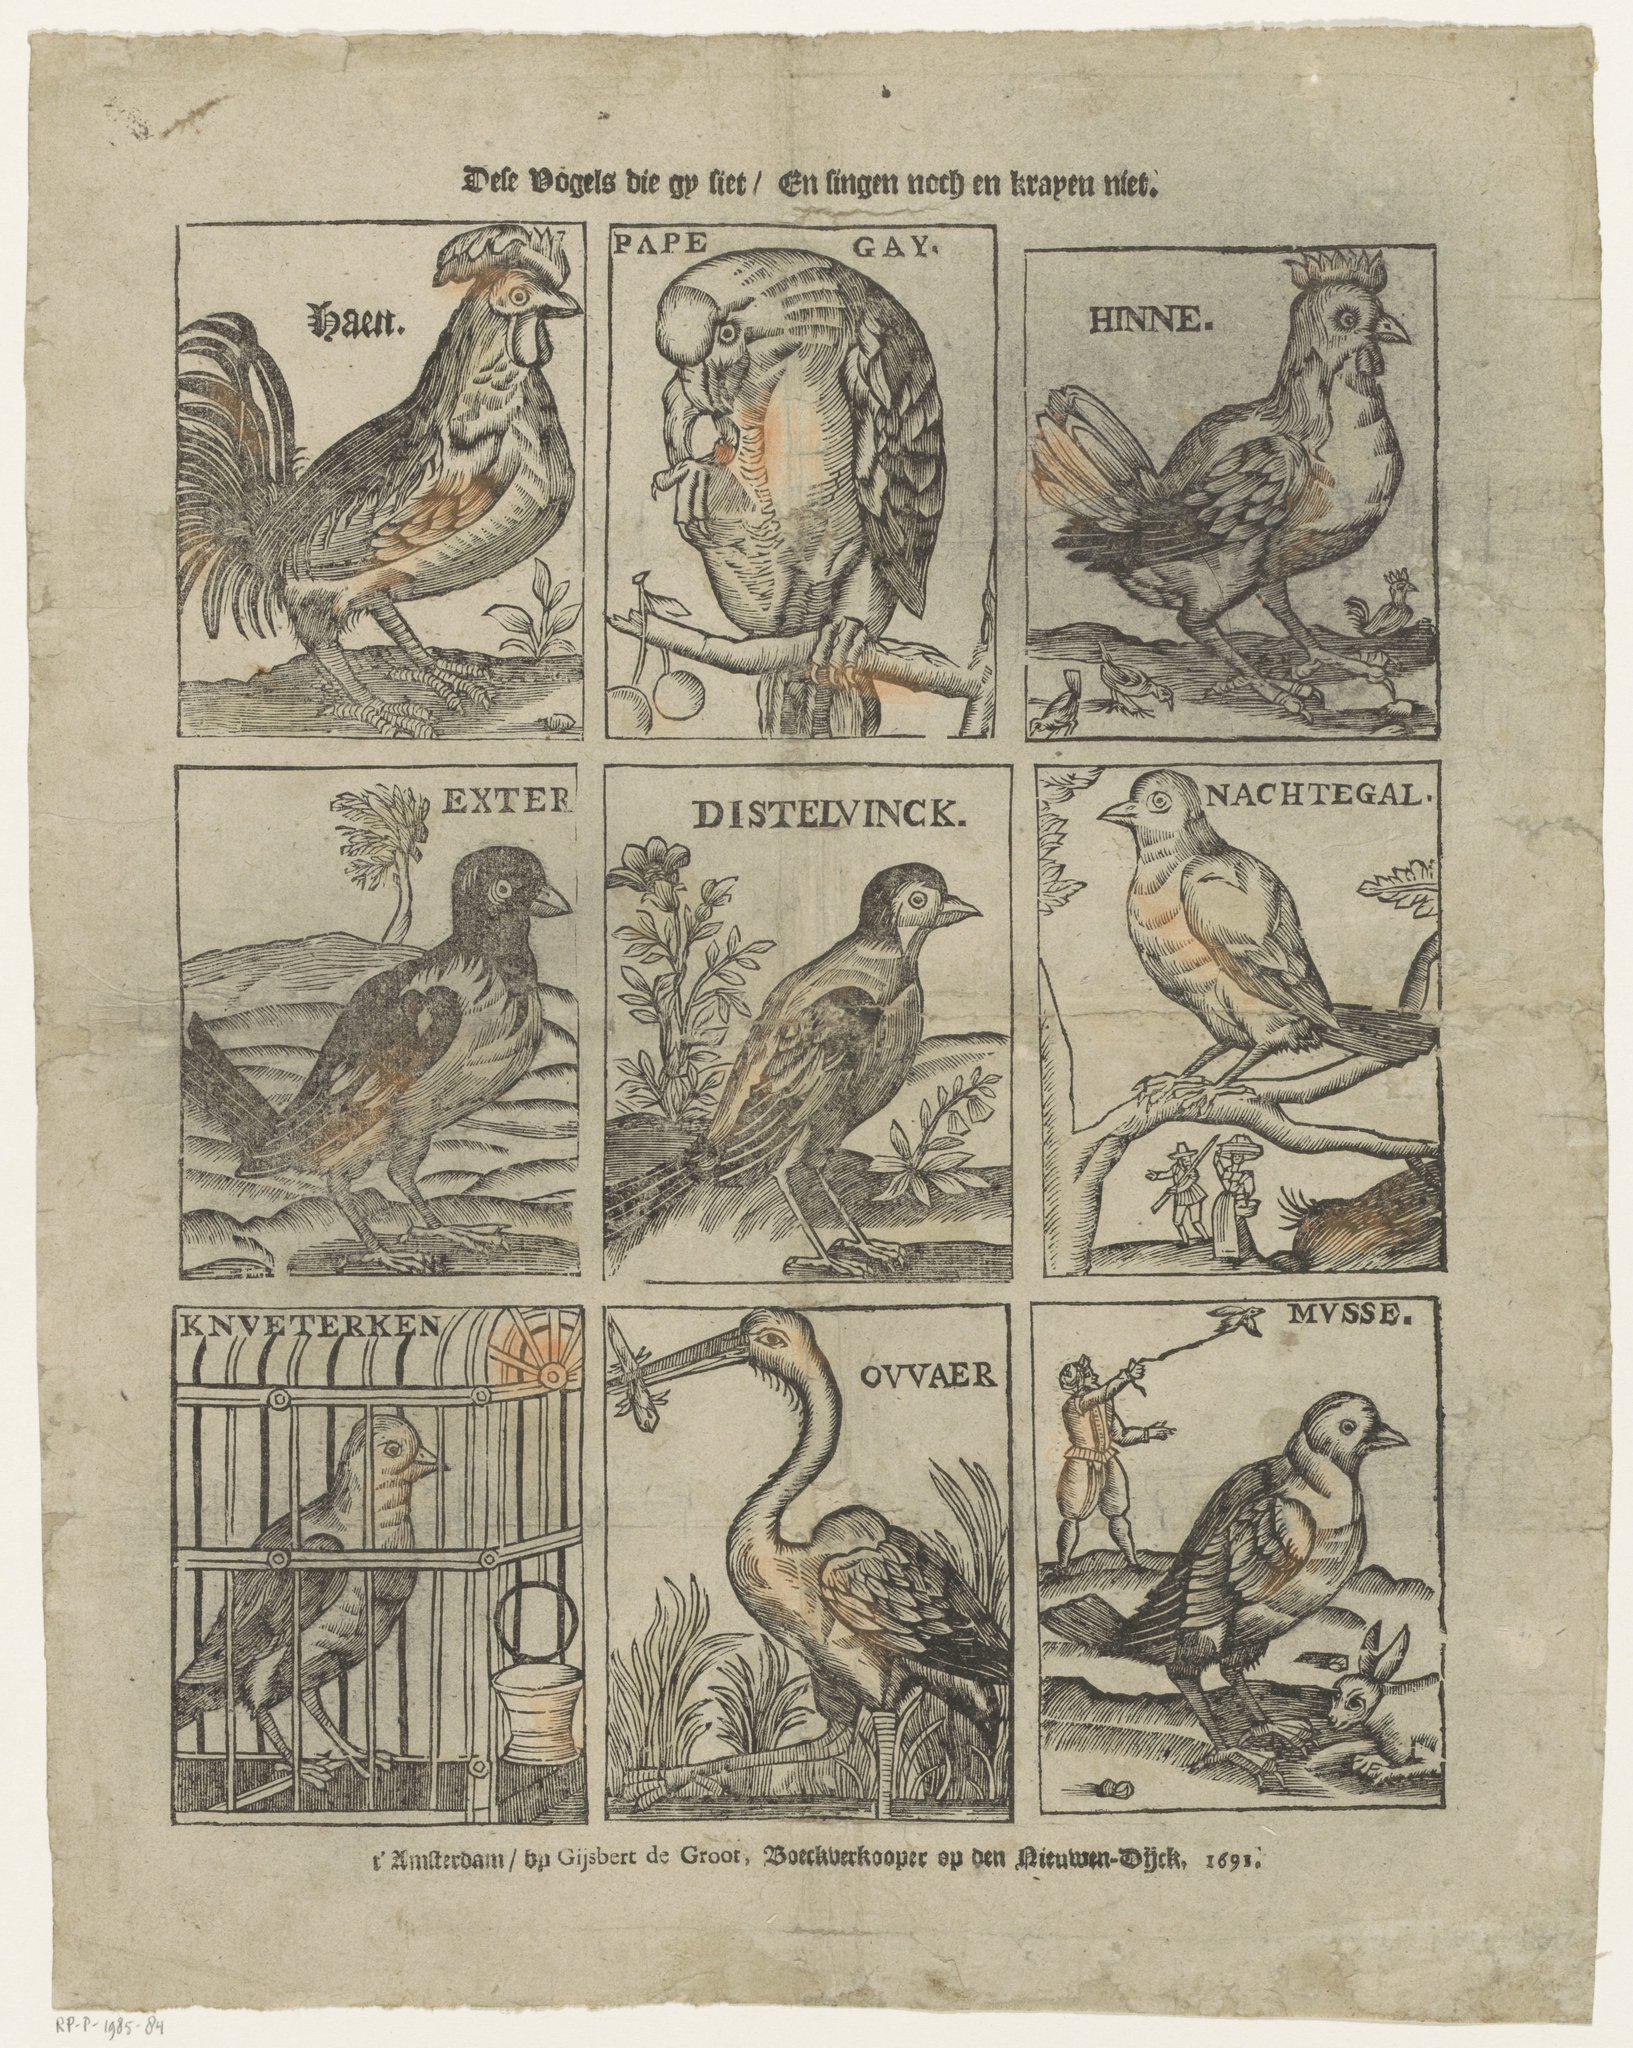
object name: print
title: Dese vogels die gy siet / En singen noch krayen niet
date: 1691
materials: paper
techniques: colour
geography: amsterdam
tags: birds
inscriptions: collector's mark: Lugt 2760, collector's mark: Lugt 2228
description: Blad met 9 voorstellingen van vogels, zoals een haan, een papegaai en een nachtegaal. In elke afbeelding de naam van de vogel.